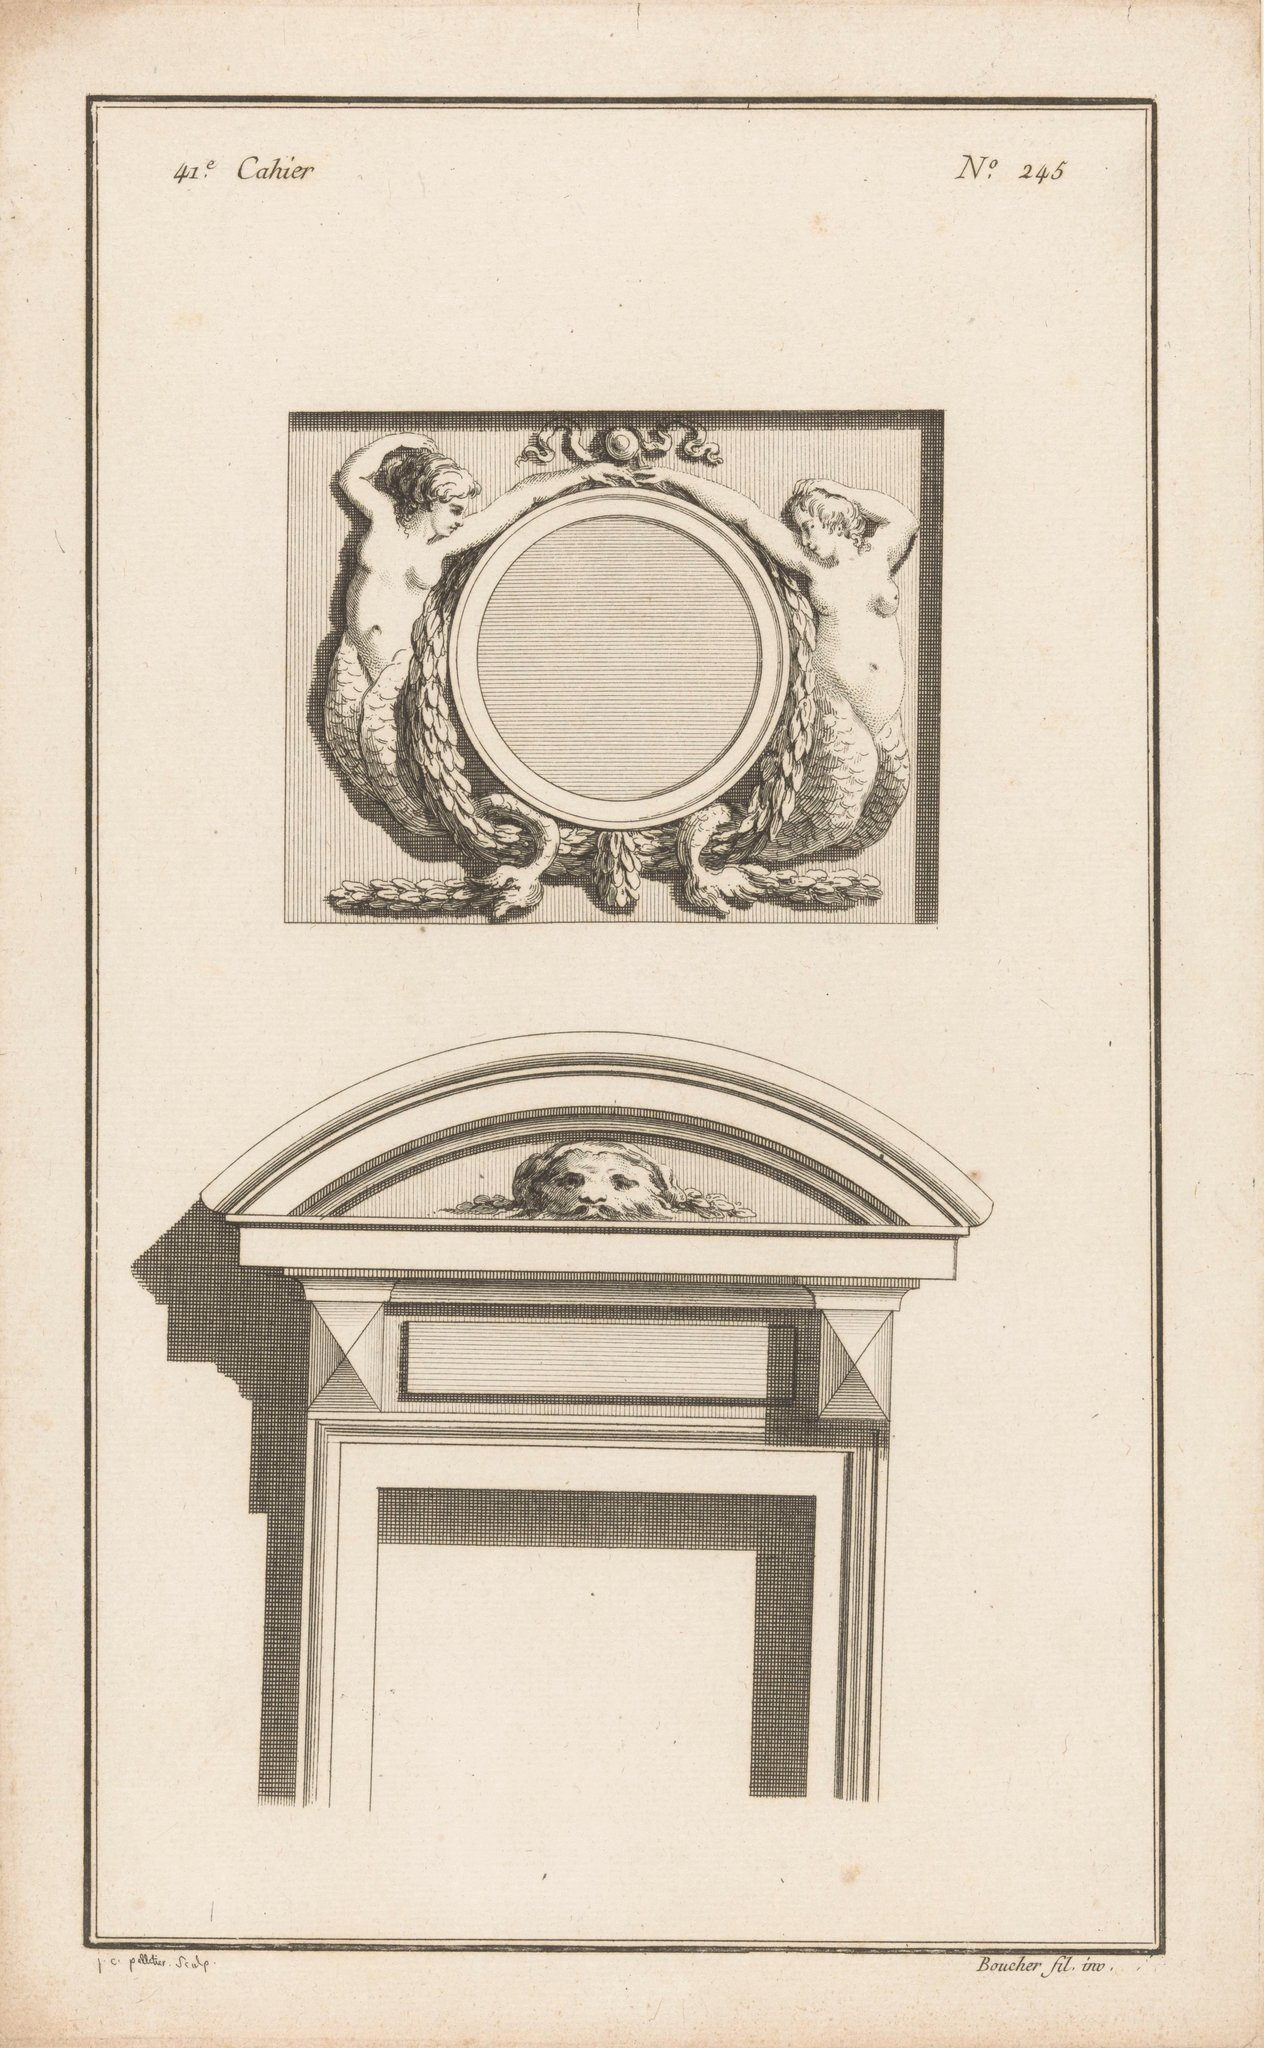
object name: ornament print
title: 41e Cahier Divers Fragmens D Architecture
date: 1772-1779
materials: paper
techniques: engraving, etching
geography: paris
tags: merman - aa - mermaid, siren, other architectural details (with name), ornament ~ medallion, door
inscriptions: collector's mark: Lugt 2228, collector's mark: Lugt 2760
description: Een paneel met twee meerminnen aan weerszijden van een rond medaillon. Daaronder een halfrond fronton boven een deur- of raamopening. Prentnummer 245.